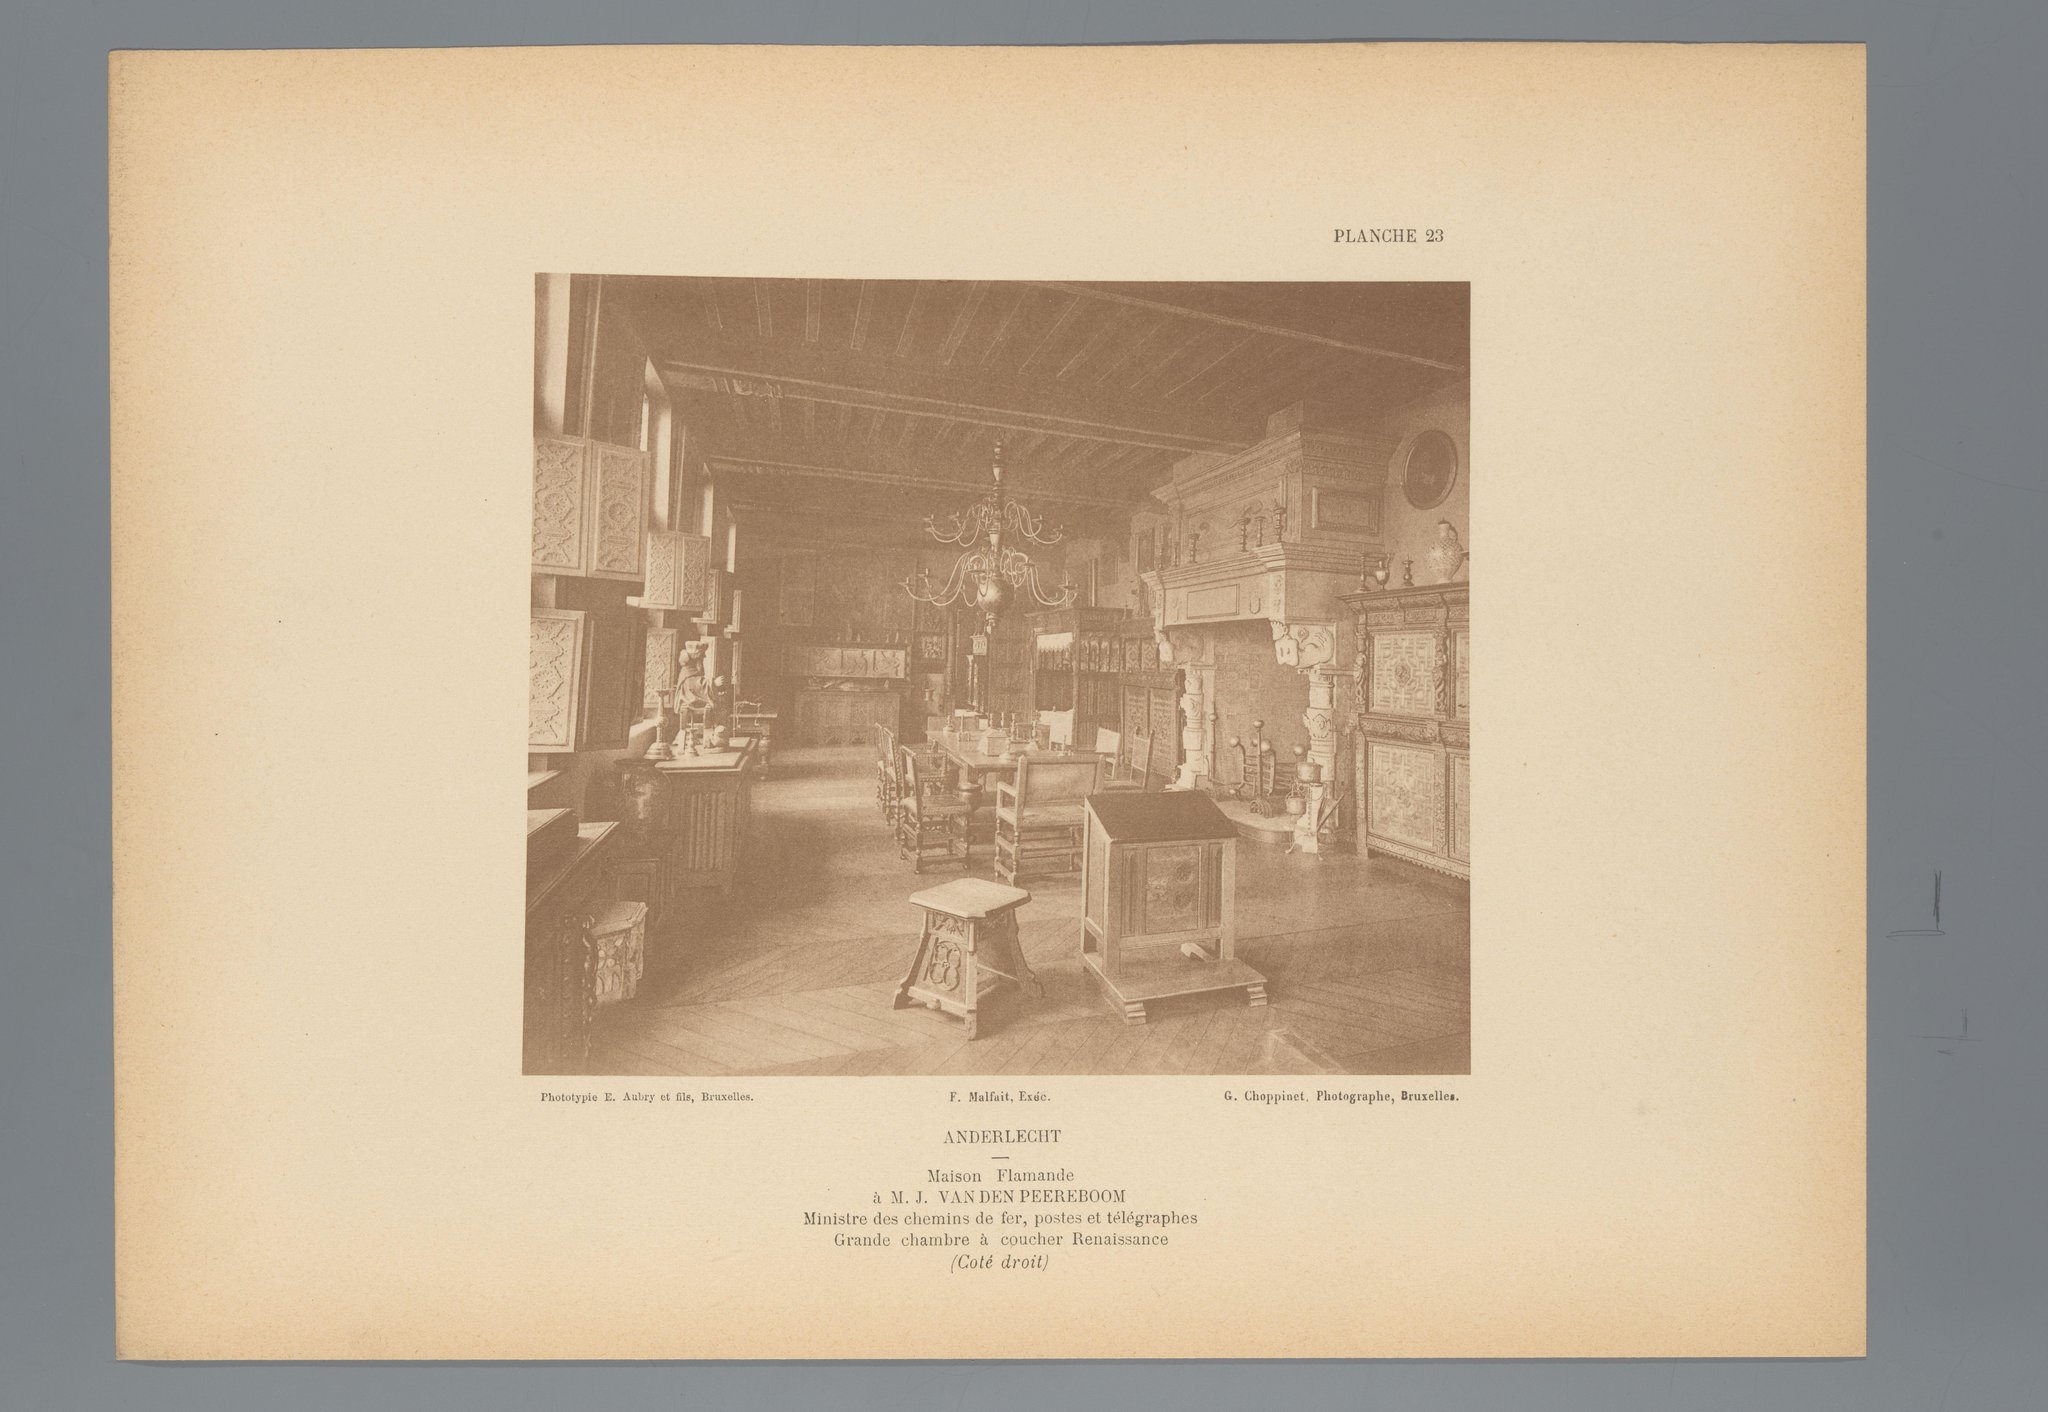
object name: photomechanical print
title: Gezicht op een slaapkamer in renaissancestijl in het huis van J. vanden Peereboom in Anderlecht, België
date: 1893-1898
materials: paper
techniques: photograph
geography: anderlecht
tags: bedroom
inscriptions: name: ‘F. Malfait, Exéc.’, inscription: ‘Maison Flamande/ à M. J. VANDEN PEEREBOOM/ Ministre des chemins de fer, postes et télégraphes/ Grande chambre à coucher Renaissance/ (Coté droit)’, number: ‘PLANCHE 23’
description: Deze prent maakt deel uit van een omslag met 89 prenten en 5 tekstbladen.